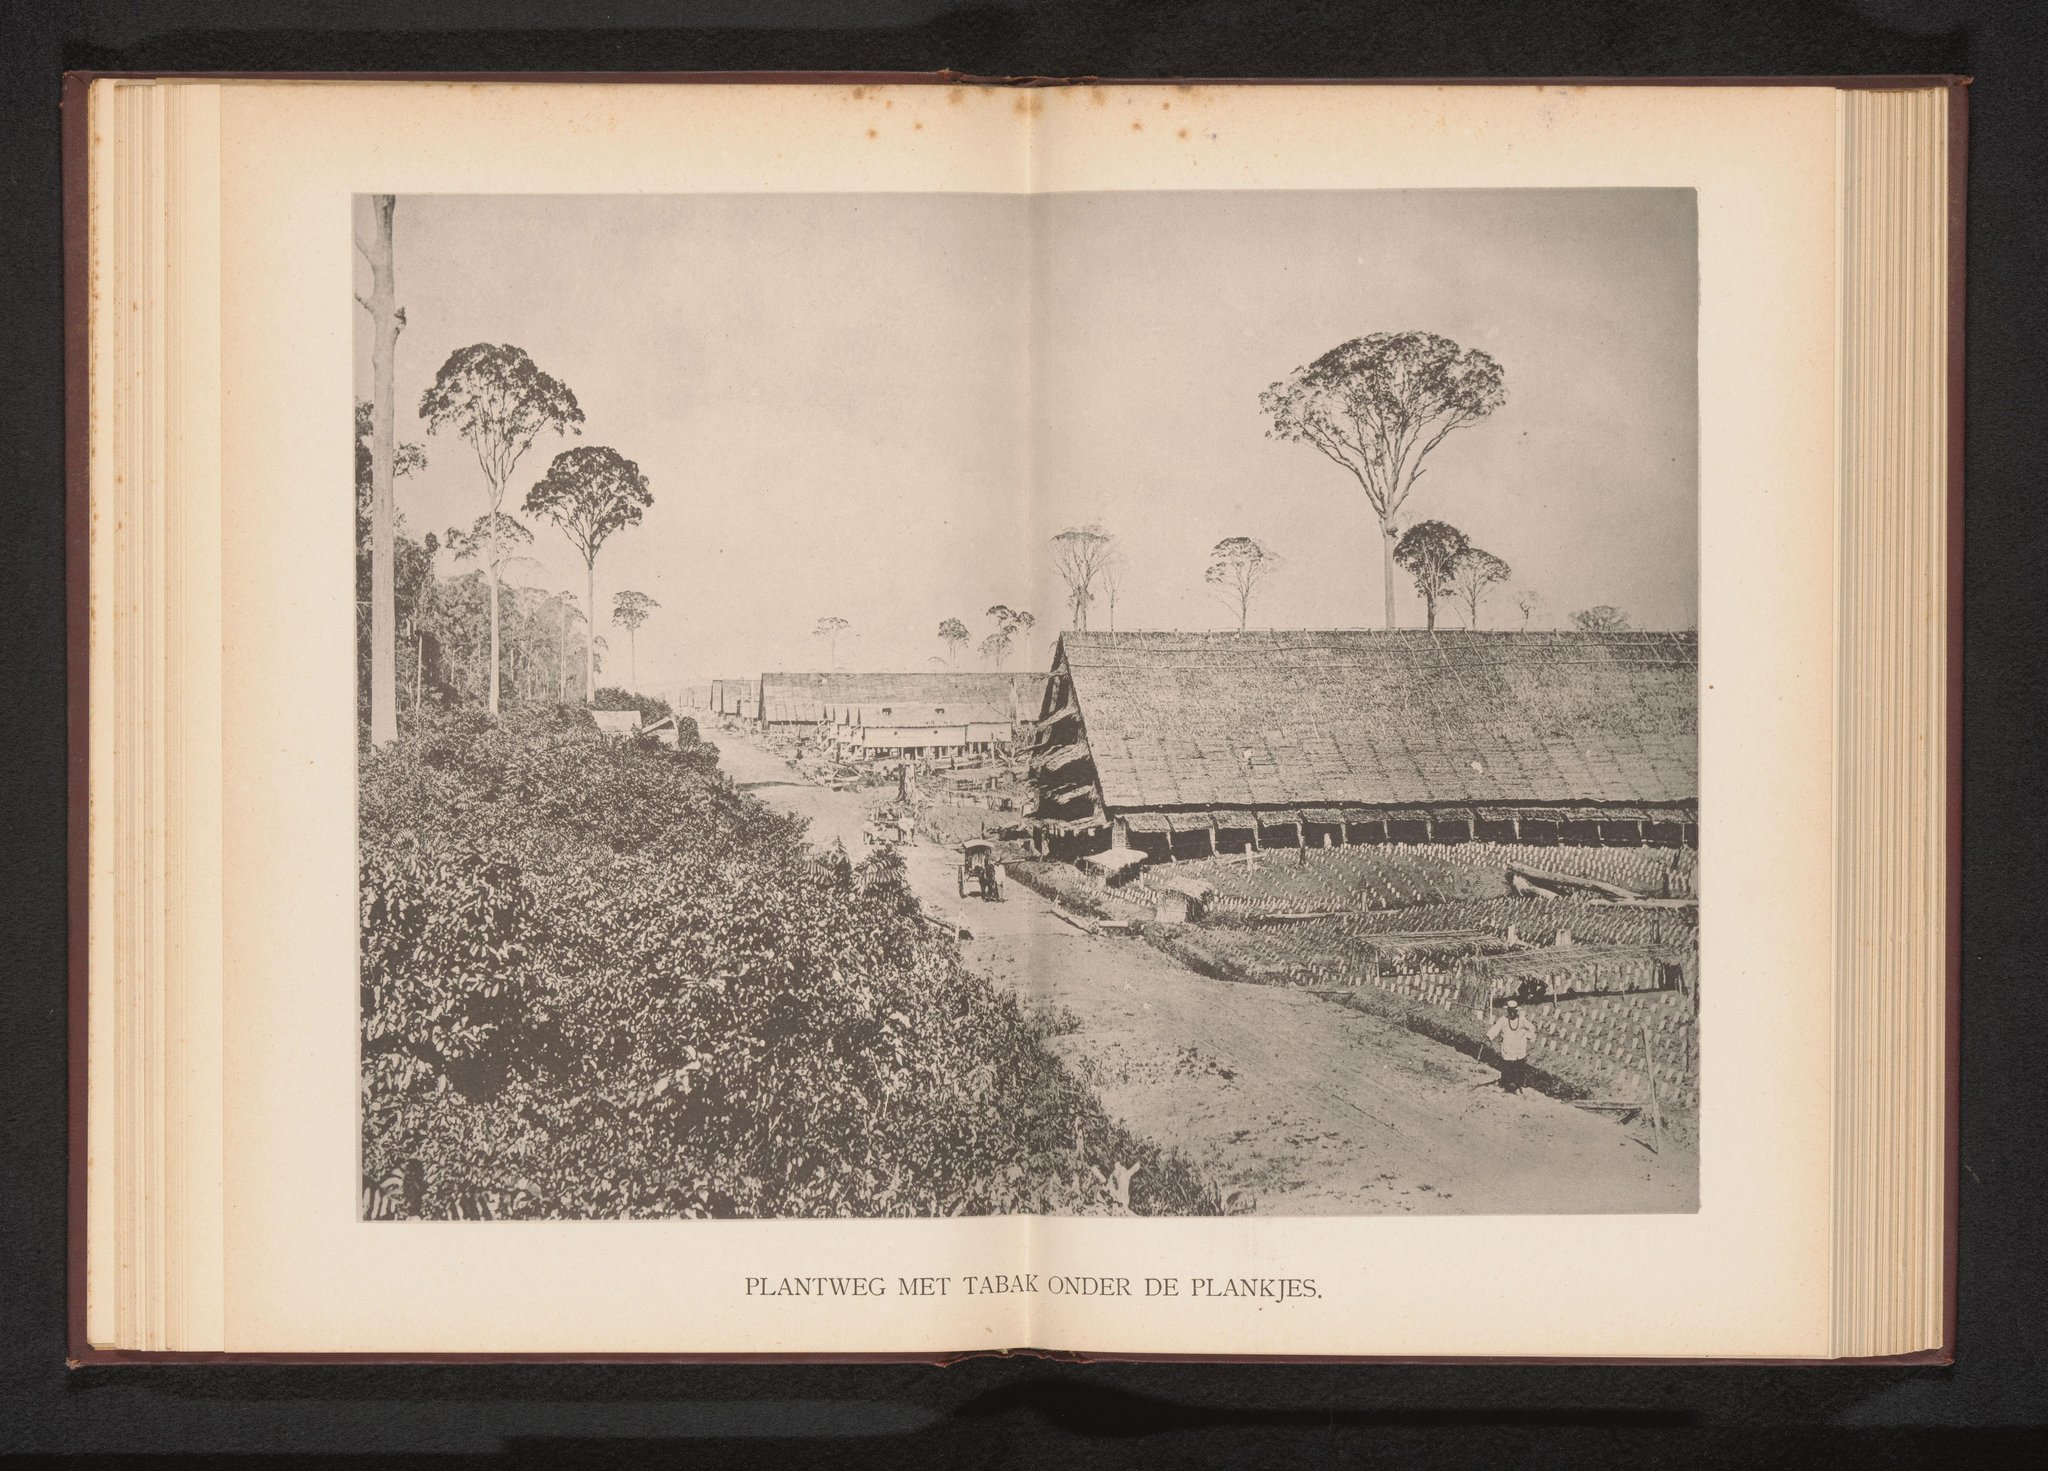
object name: page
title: Plantweg met tabak onder de plankjes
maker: Anonymous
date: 1884-1889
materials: paper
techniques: photograph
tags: plantation, tobacco, sumatra